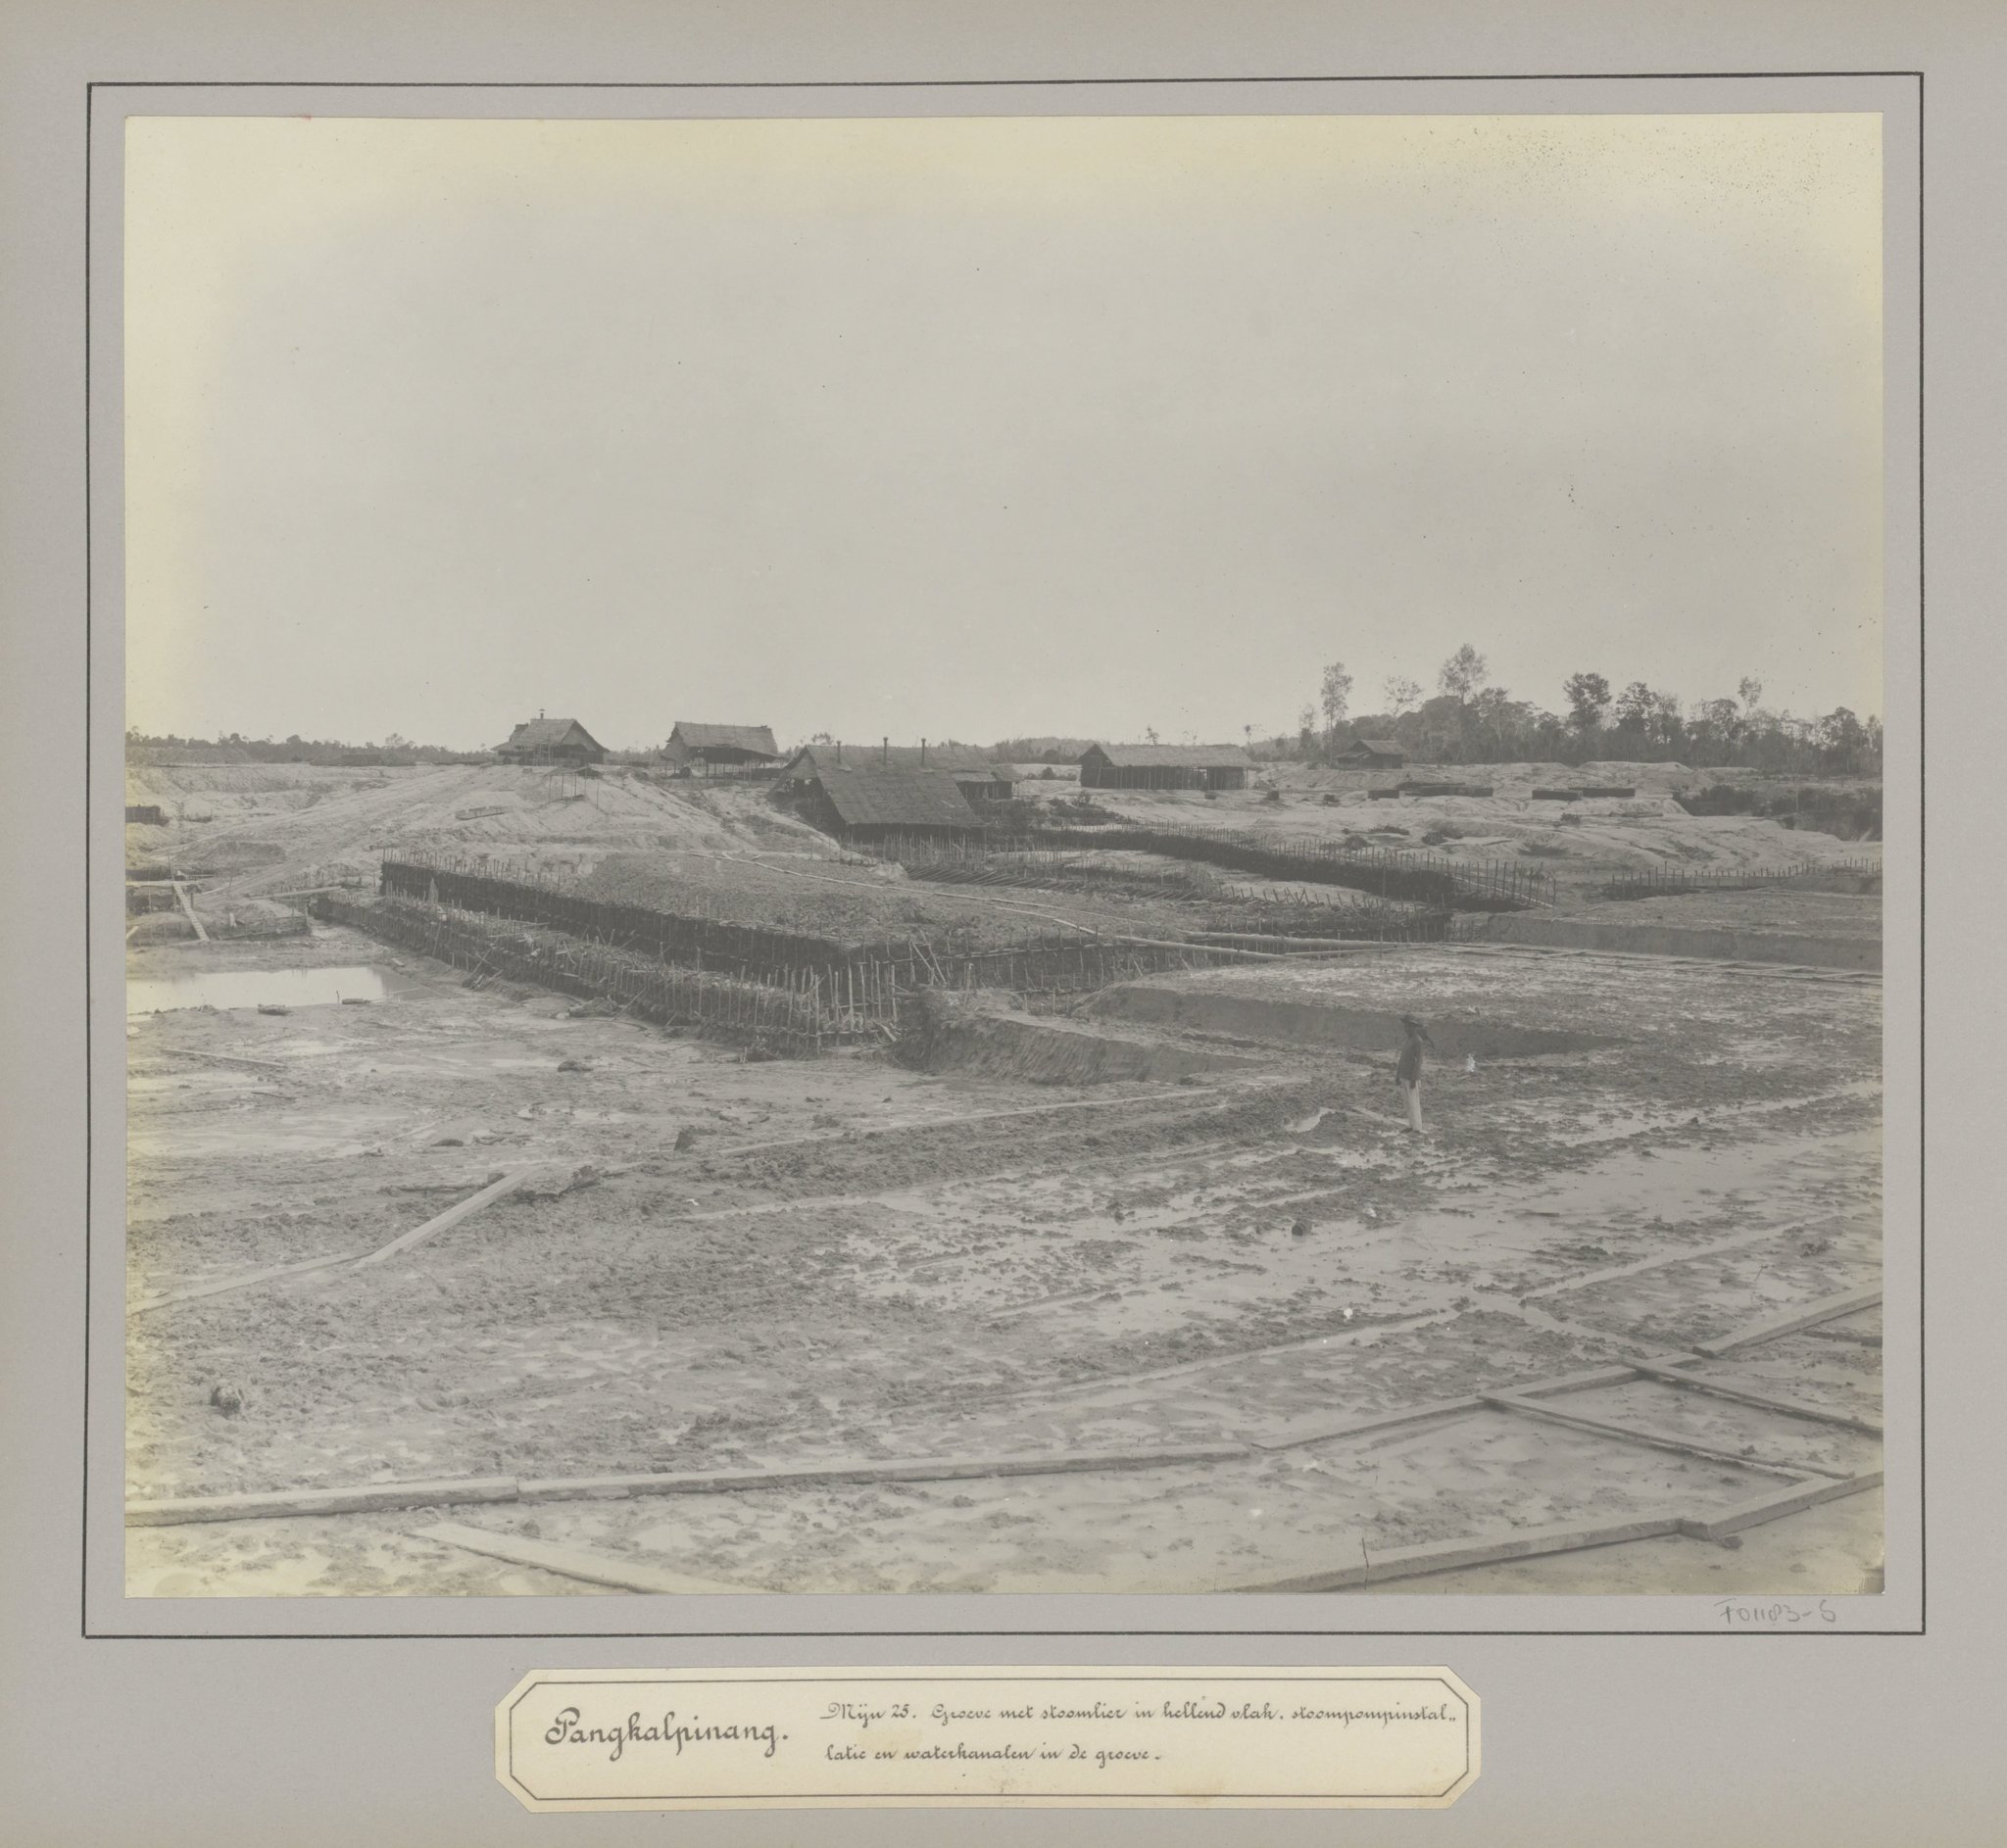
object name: photograph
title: Tingroeve in Pangkalpinang met stoomlier en pompinstallatie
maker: Anonymous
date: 1900-1920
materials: photographic support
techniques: gelatin silver print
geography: pangkalpinang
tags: mining, minerals and metals: tin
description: Onderdeel van Fotoalbum over de tinwinning op Bangka.